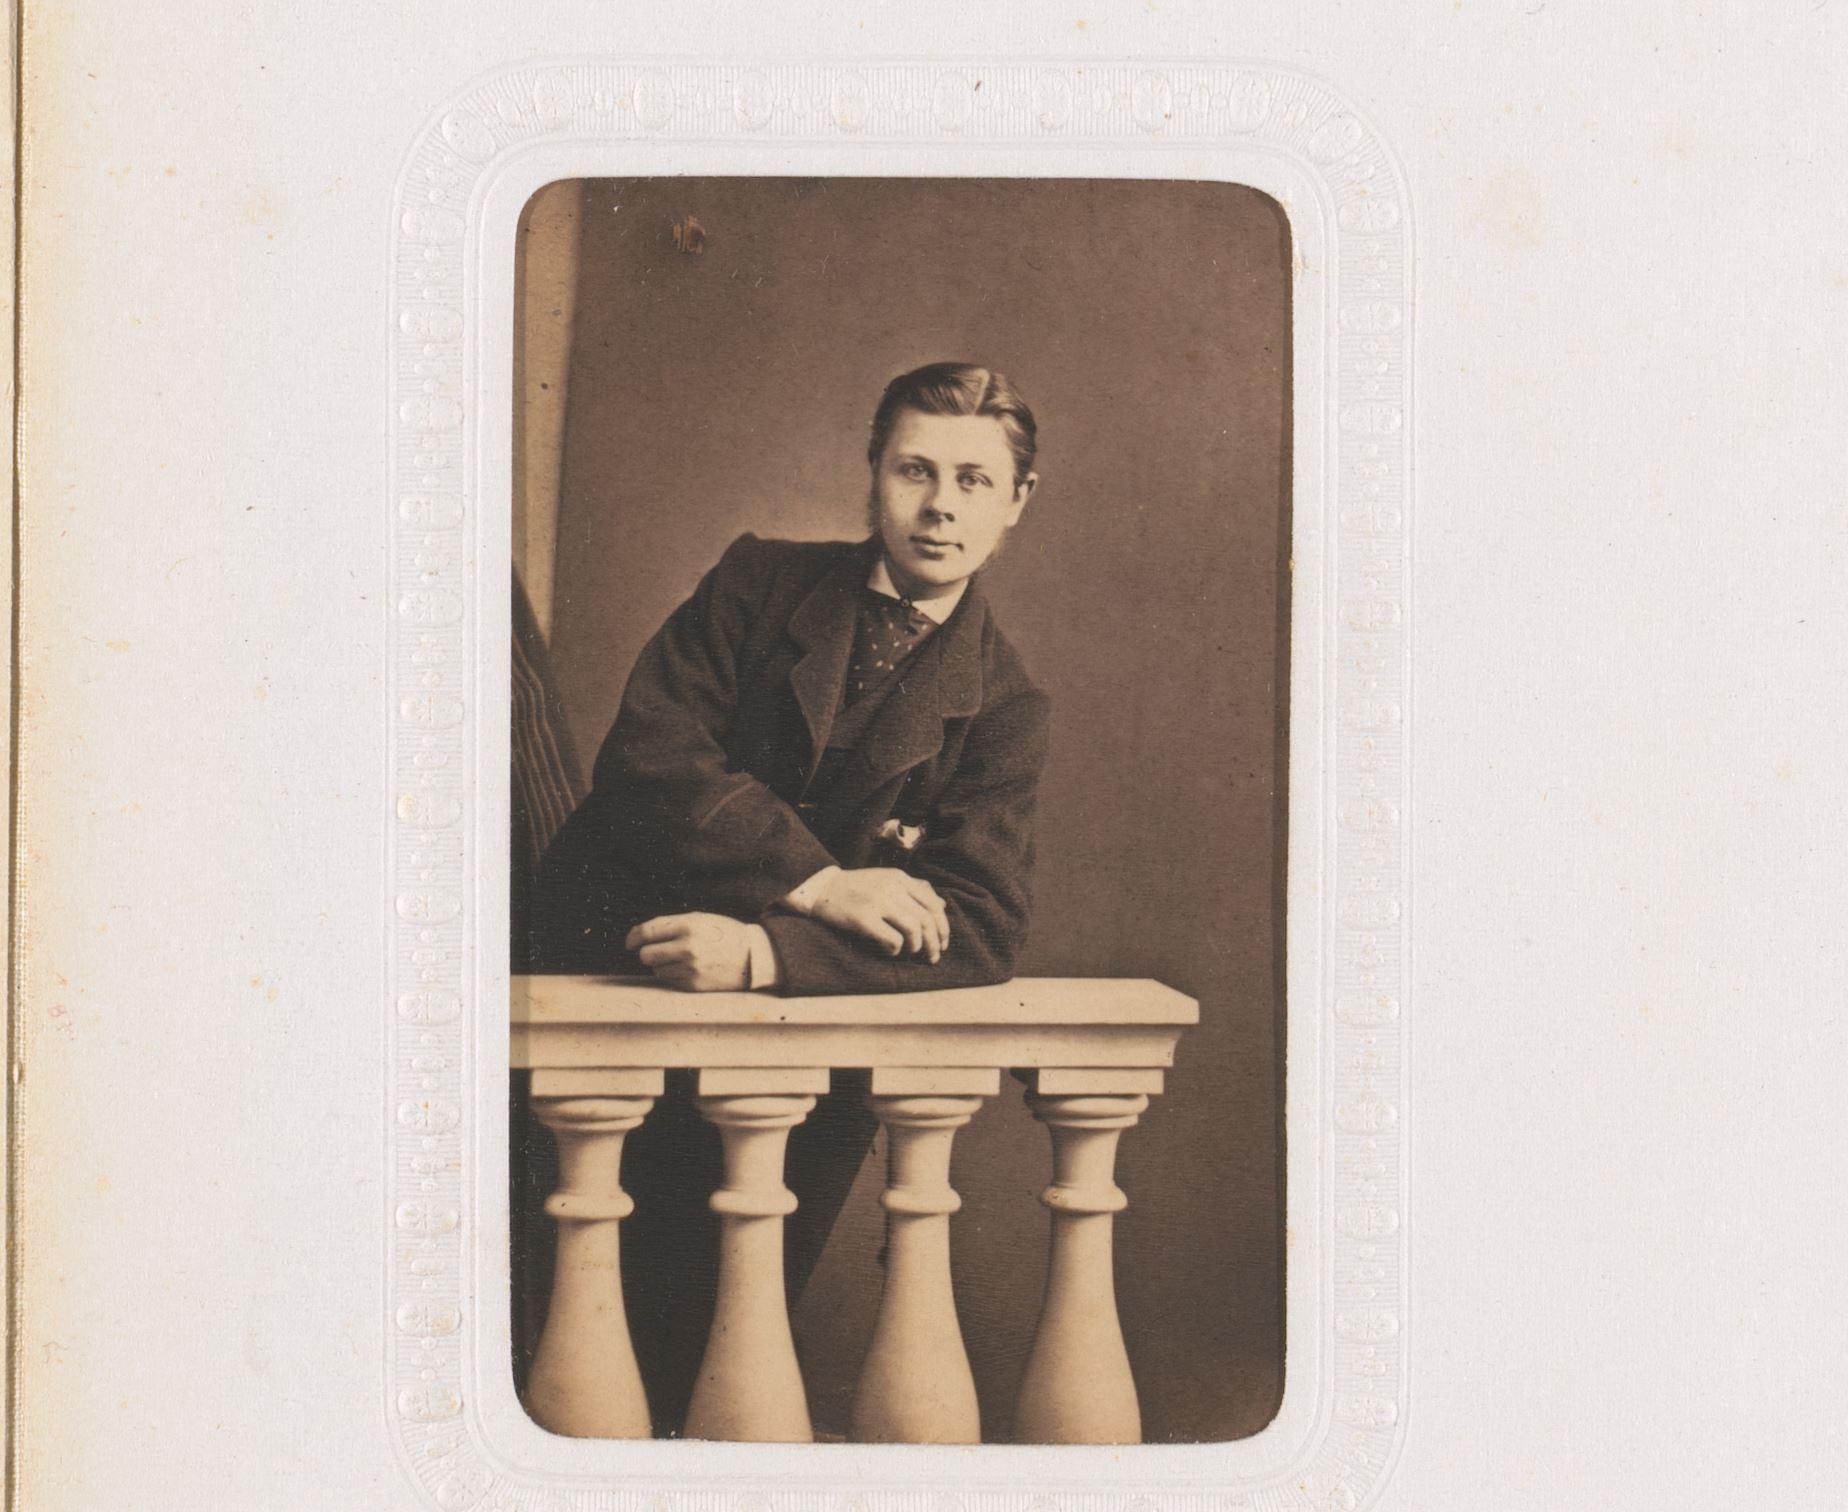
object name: carte de visite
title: Portret van een jongeman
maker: Anonymous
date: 1850-1880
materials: cardboard, photographic support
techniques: albumen print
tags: historical persons